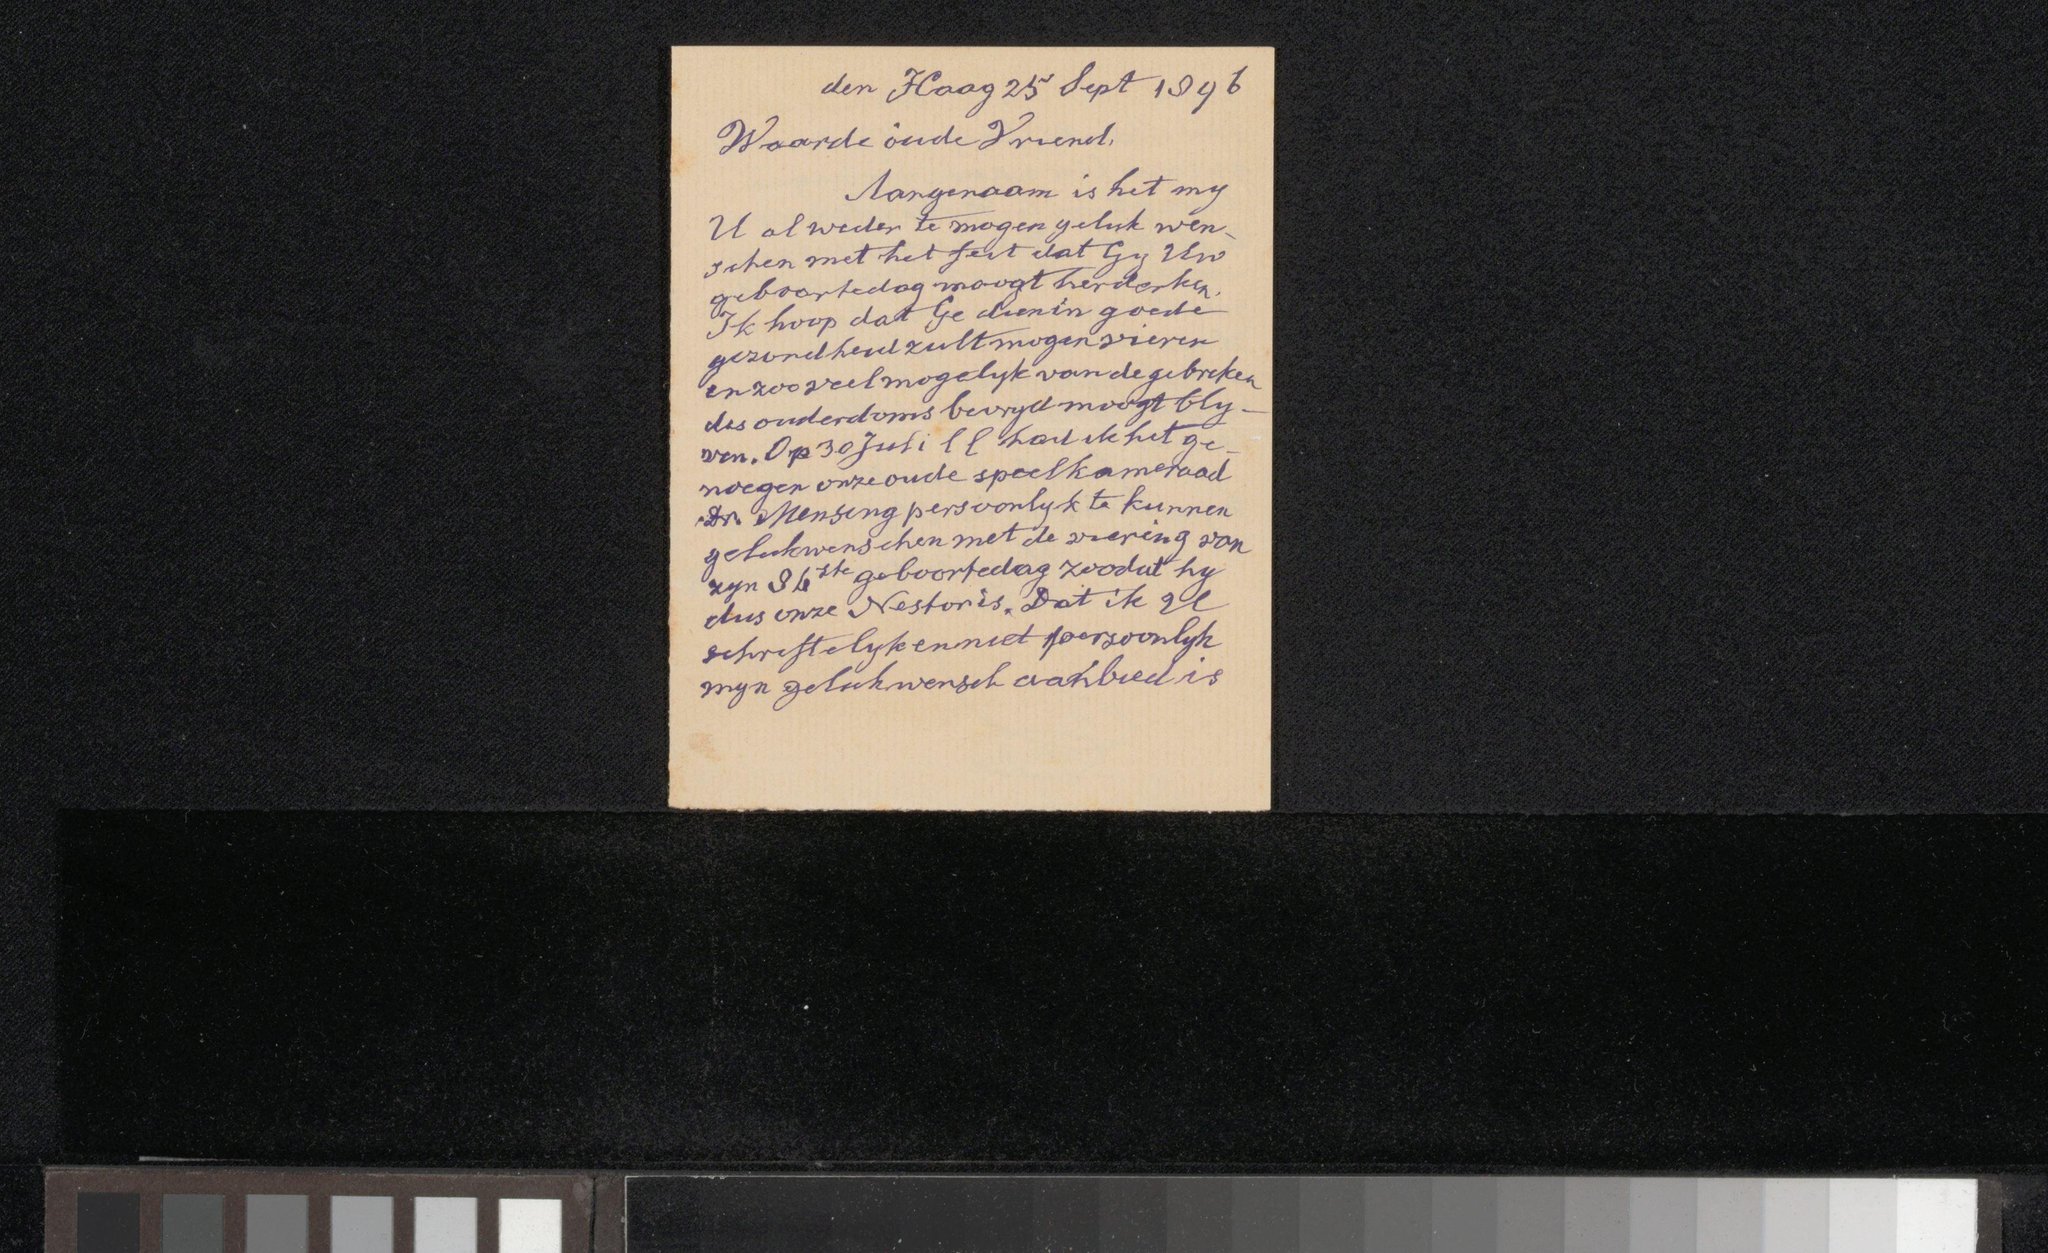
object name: letter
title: Brief aan Ary Johannes Lamme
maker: johan eliza de vrij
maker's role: scheikundige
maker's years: 1813-1898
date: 1896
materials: ink, paper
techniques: pen, writing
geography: the hague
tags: dordrecht, print maker, draughtsman, ary johannes lamme, travelling; tourism, nijmegen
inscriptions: collector's mark: Lugt 2228, watermark